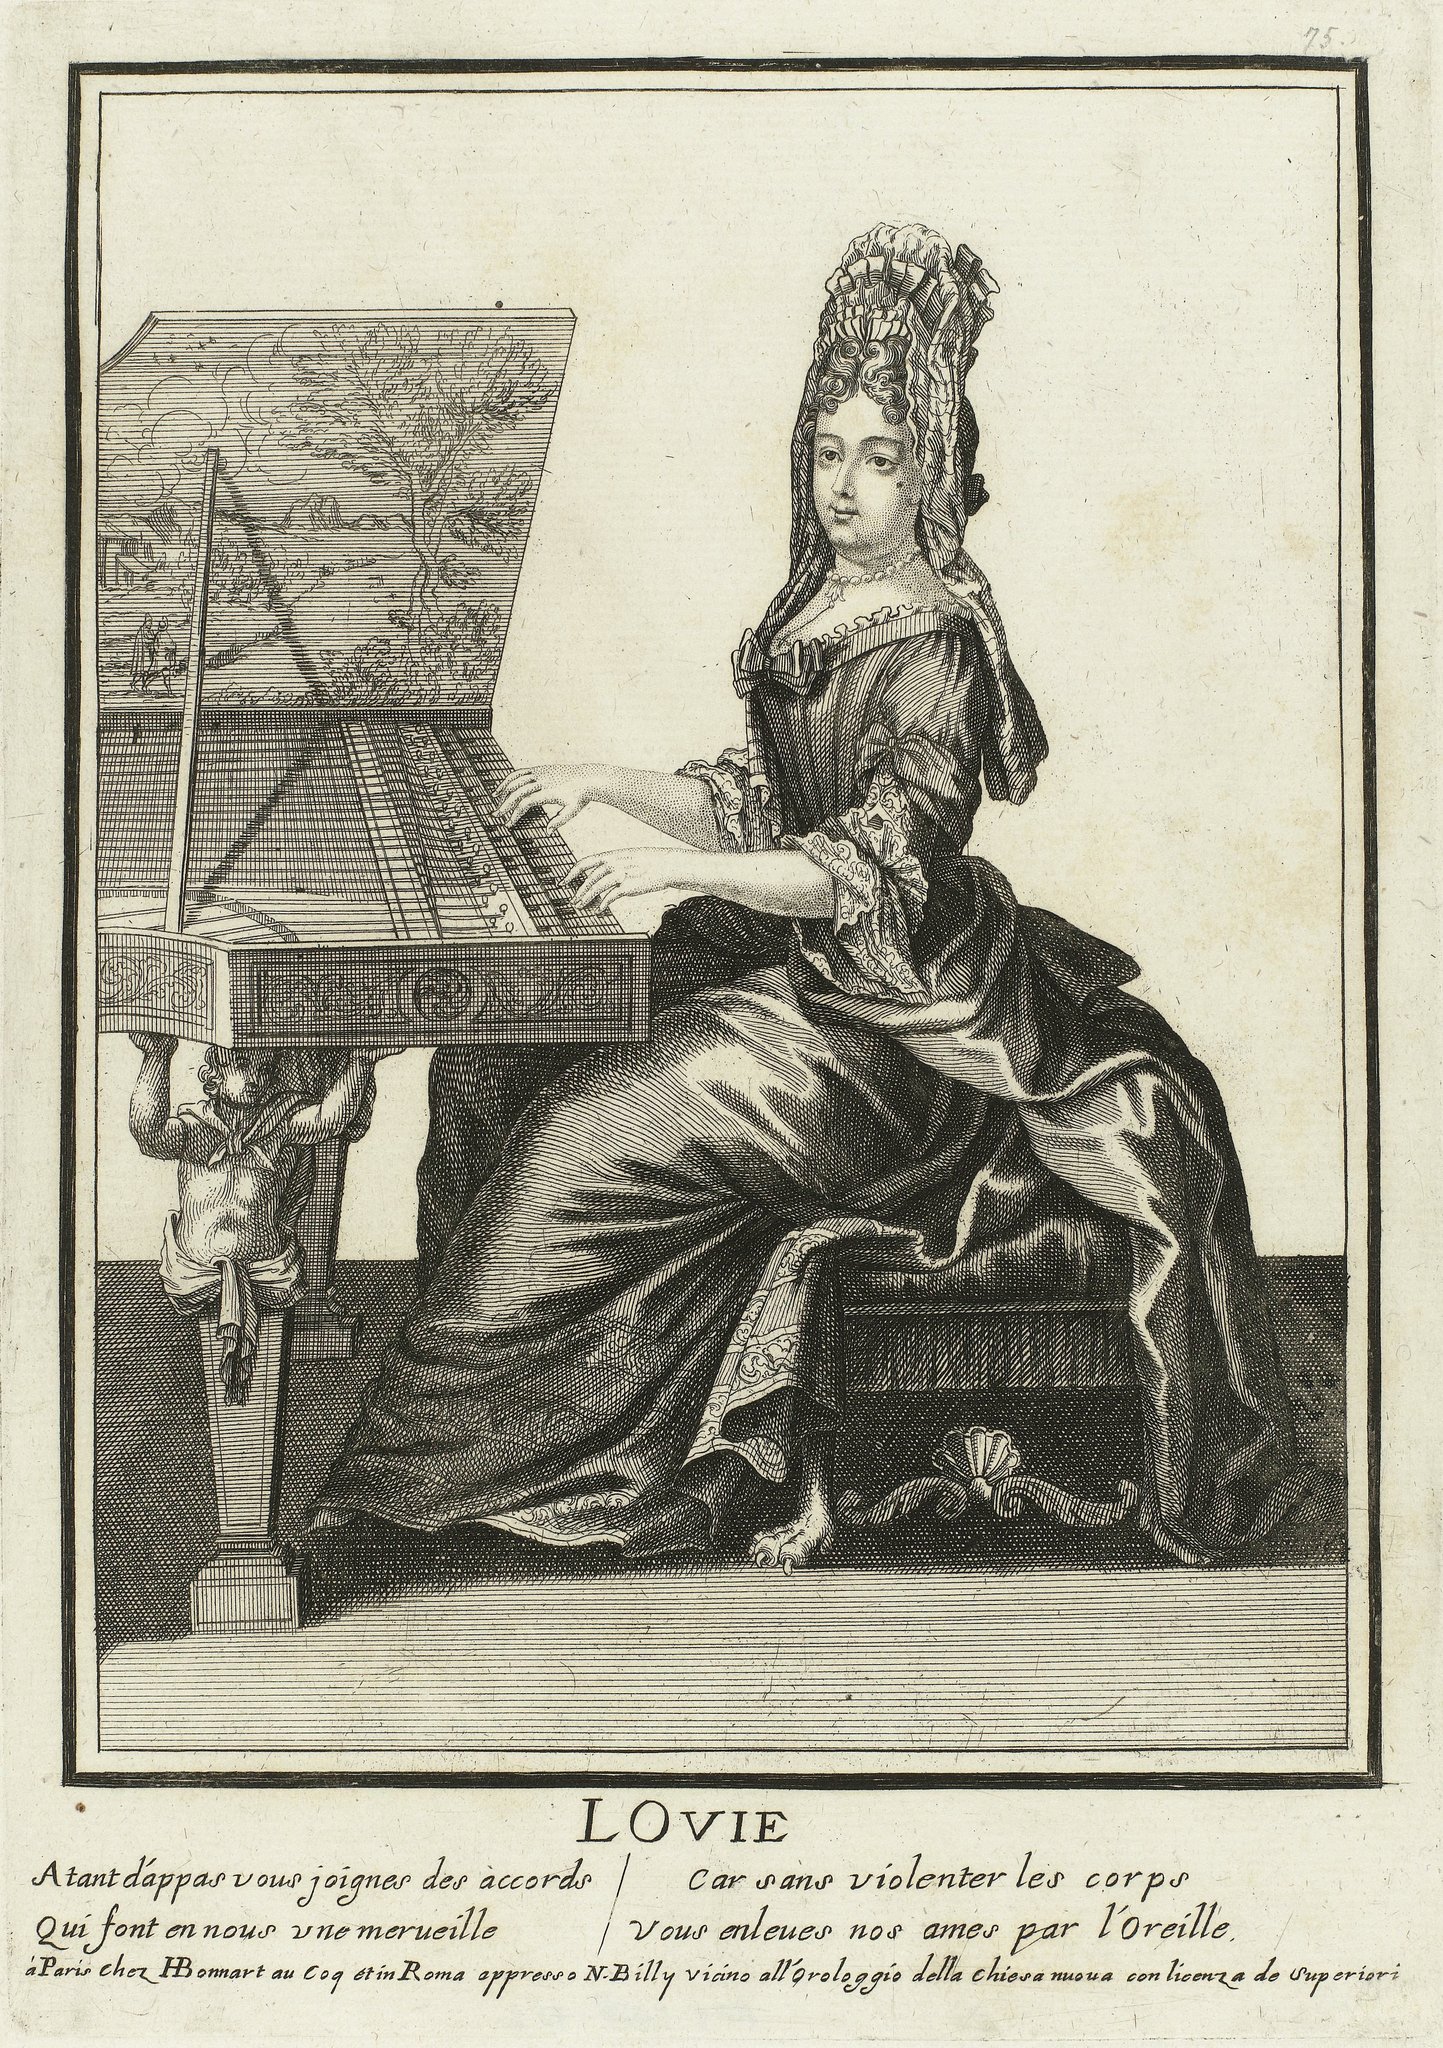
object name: print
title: Personificaties van de vijf zintuigen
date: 1652-1711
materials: paper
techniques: engraving, etching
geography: france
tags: hearing, listening (one of the five senses), styles of hairdress - aa - ~ women, clavichord, harpsichord, head-gear: fontange (+ women's clothes), dress, gown: manteau (+ women's clothes), necklace (+ women's clothes)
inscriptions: address: ‘A Paris chez HBonnart au Coq et in Roma appresso N. Billy.....superiori’, collector's mark: Lugt 2228, collector's mark: Lugt 2760, poem: ‘A tant d'appas vous joignes des accords....vous enleves nos ames par l'Oreille’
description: Maakt deel uit van een serie met personificaties van de vijf zintuigen, uitgegeven door Henri Bonnart in Parijs en Rome. Een spiegelbeeldige versie bevindt zich in de collectie van het British Museum te Londen, inv.nr. 1922,0410.168.